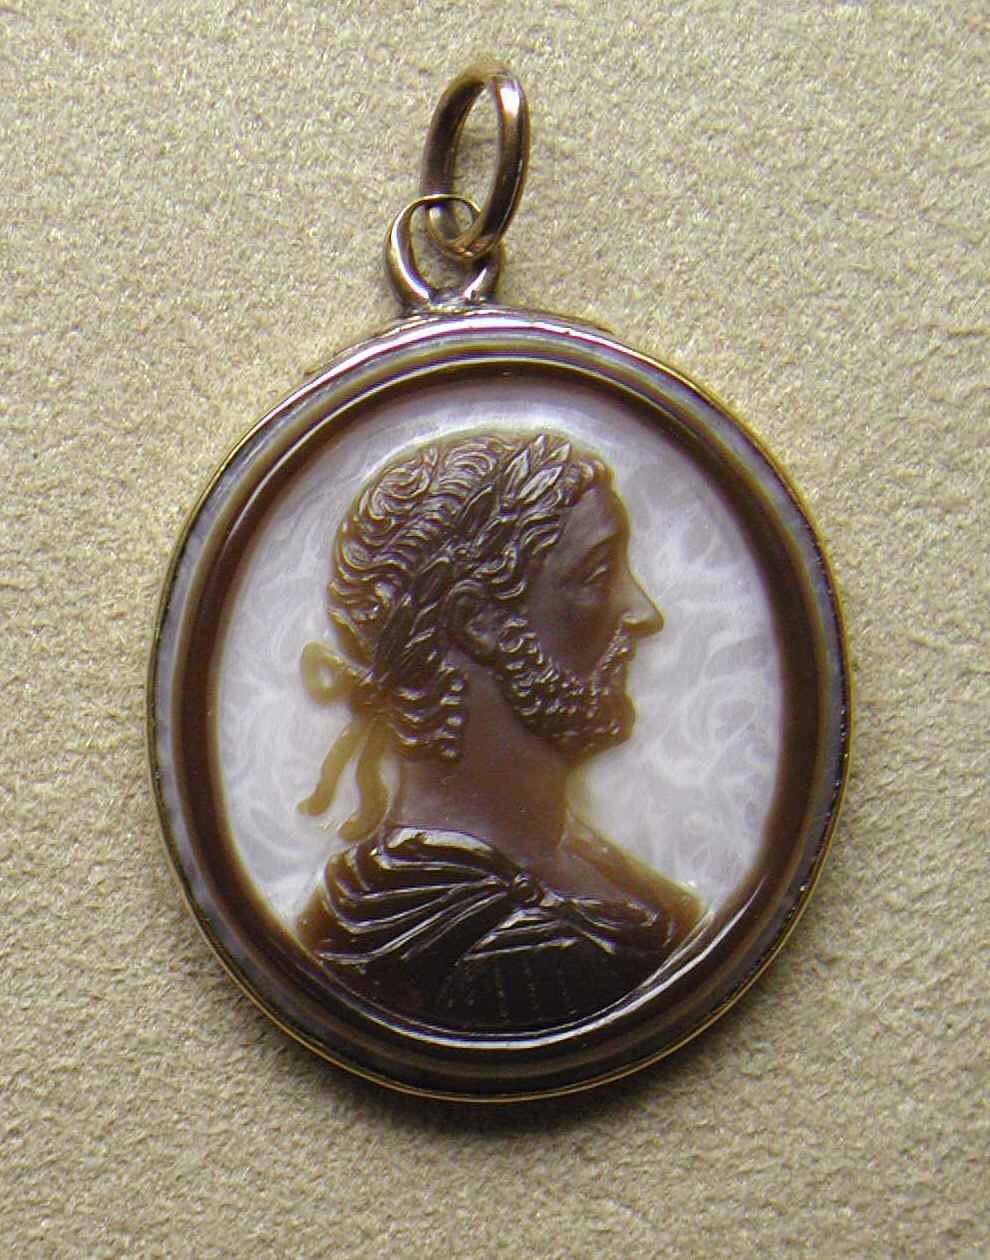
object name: cameo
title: Antoninus Pius (Titus Aurelius Fulvus Boionius Arrius Antoninus, 86–161) (?)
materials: gold, gemstone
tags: men,profiles